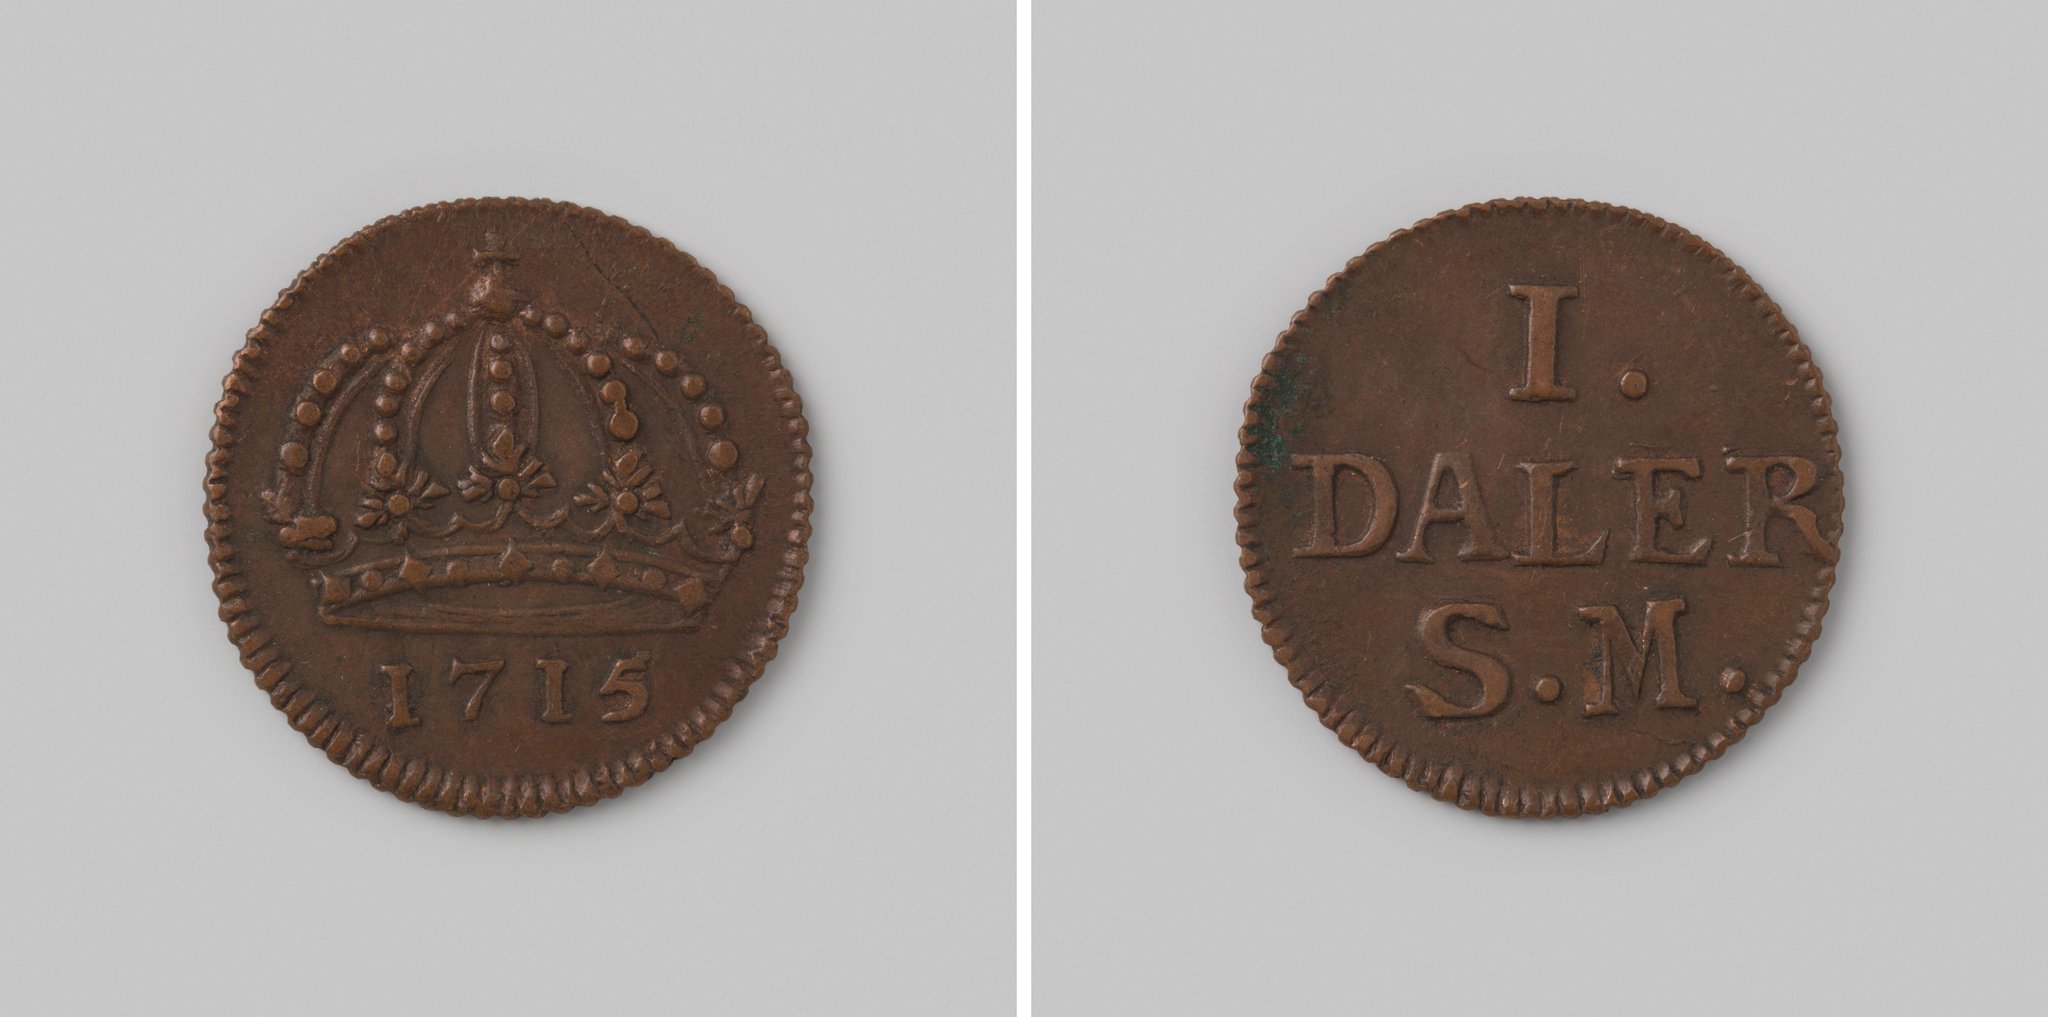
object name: daler silvermynt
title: Zweden, Karel XII, daler S[ilver] M[ynt], 1715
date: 1715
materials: copper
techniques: striking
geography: slot rörstrand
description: Koperen noodmunt. Voorzijde: kroon, waaronder jaartal. Keerzijde: in drie regels waarde-aanduiding. Kartelrand.